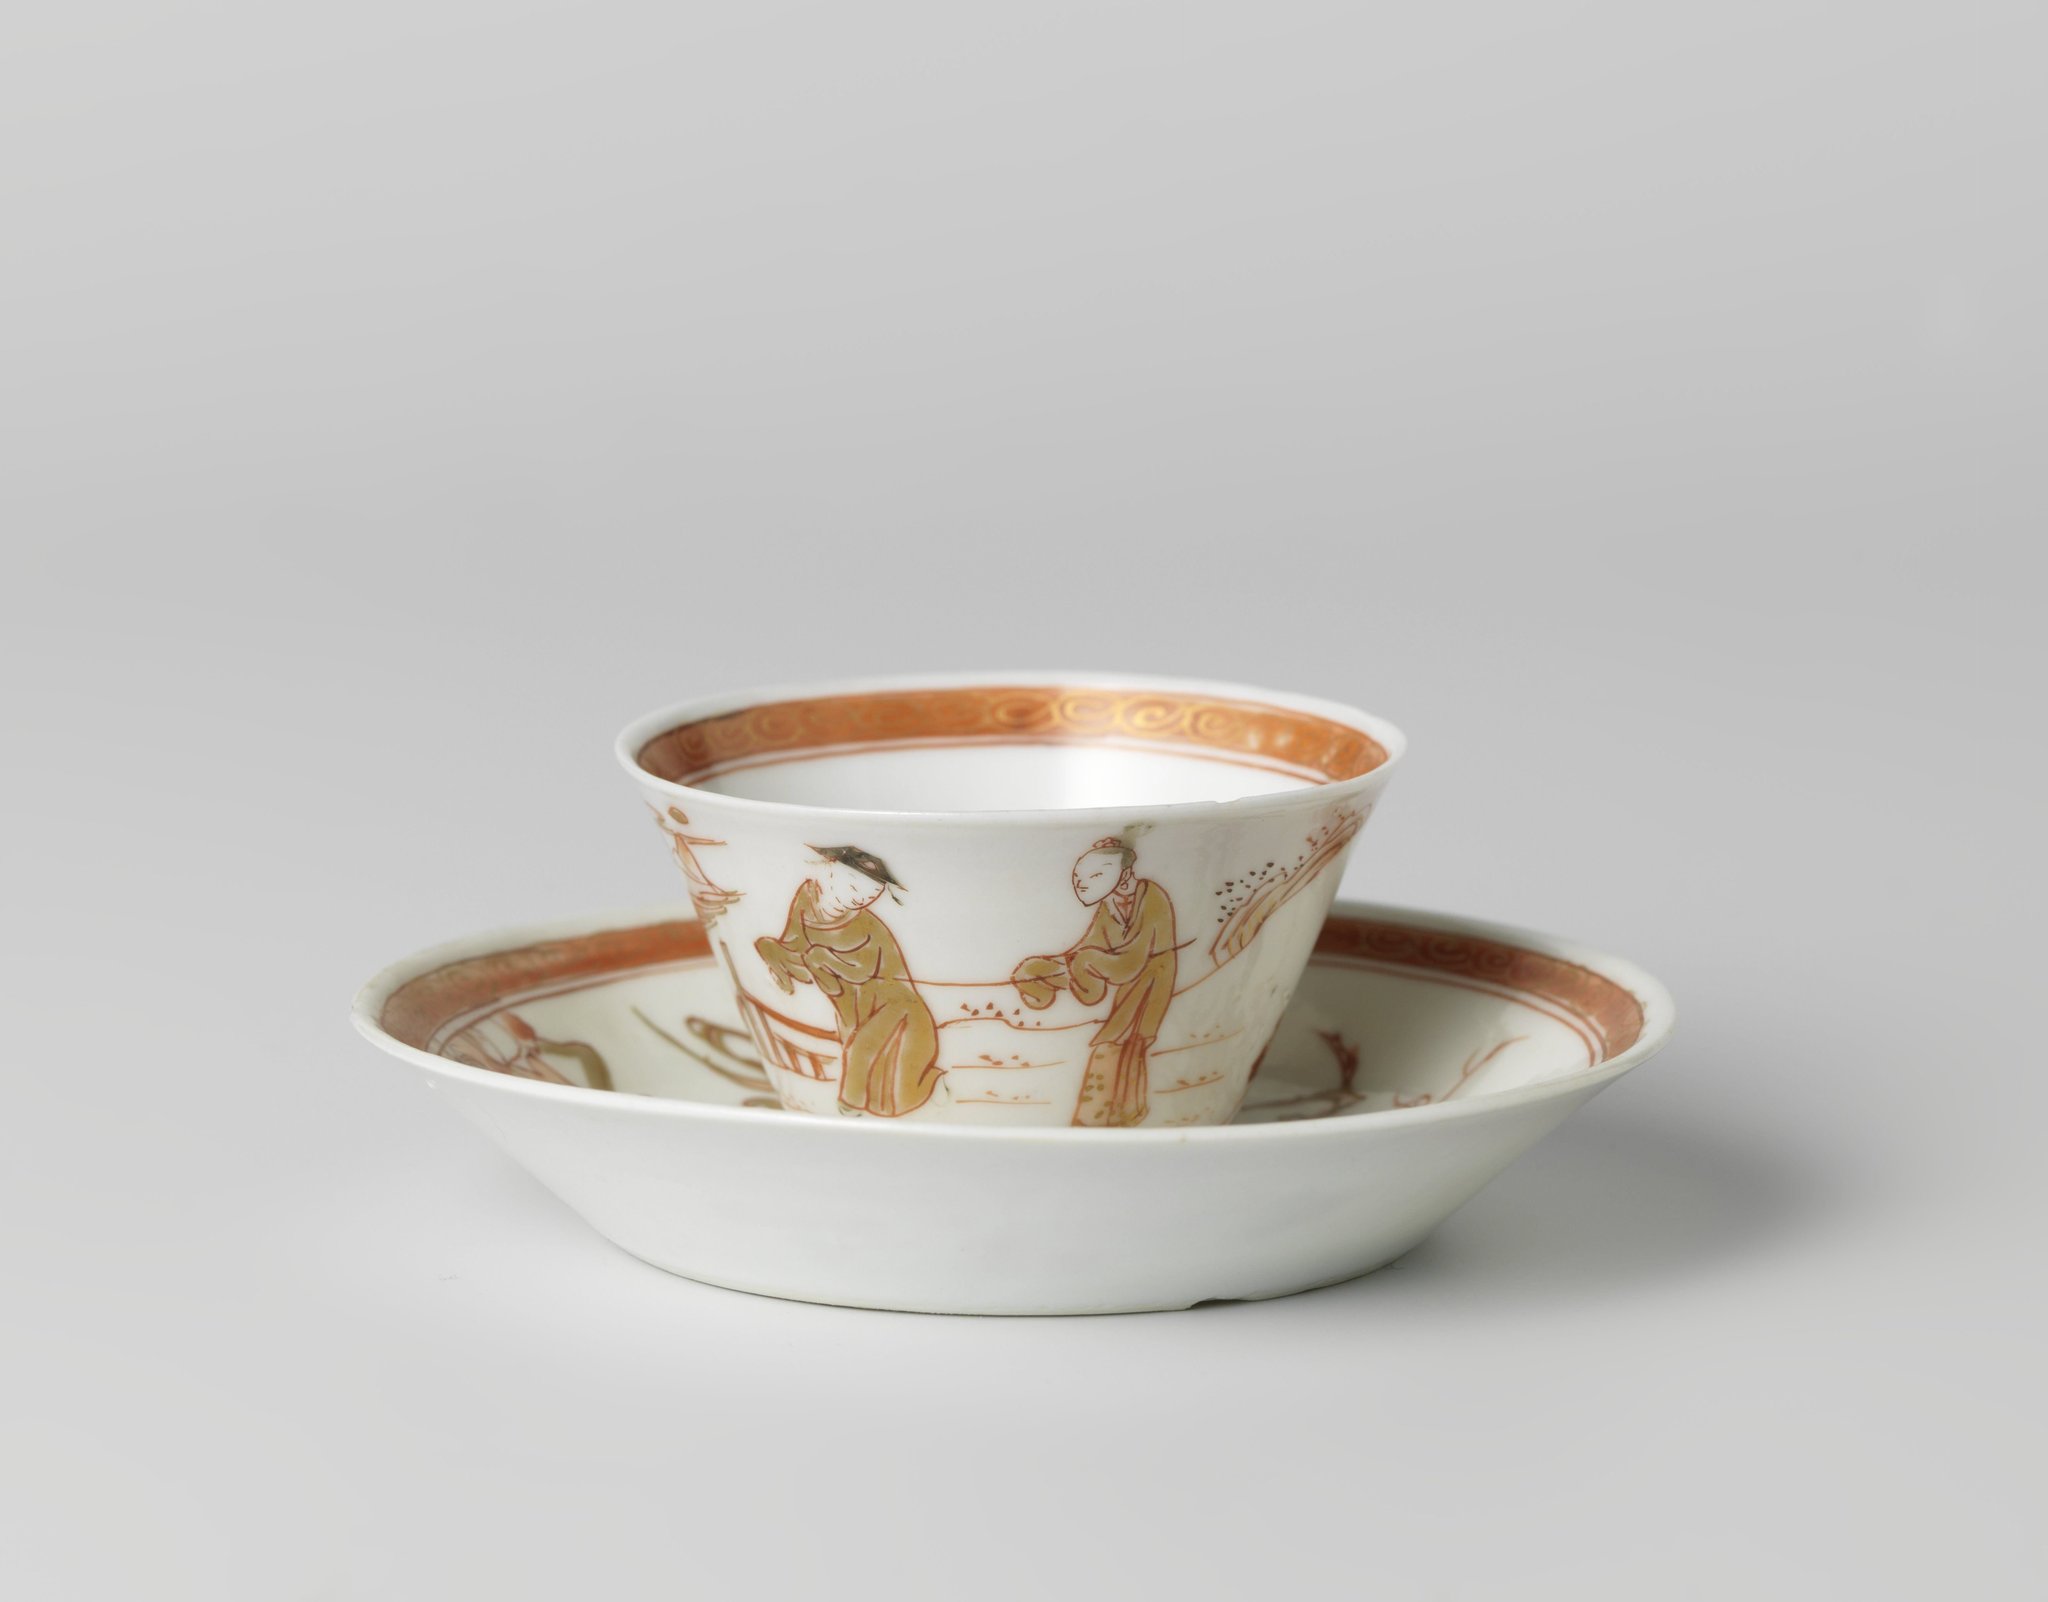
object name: kop en schotel, kop en schotel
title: Cup and saucer with two figures in a water landscape and a flowering tree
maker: Anonymous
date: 1700-1724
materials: glaze, gold, paint, porcelain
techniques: firing, gilding, turning, vitrification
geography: china